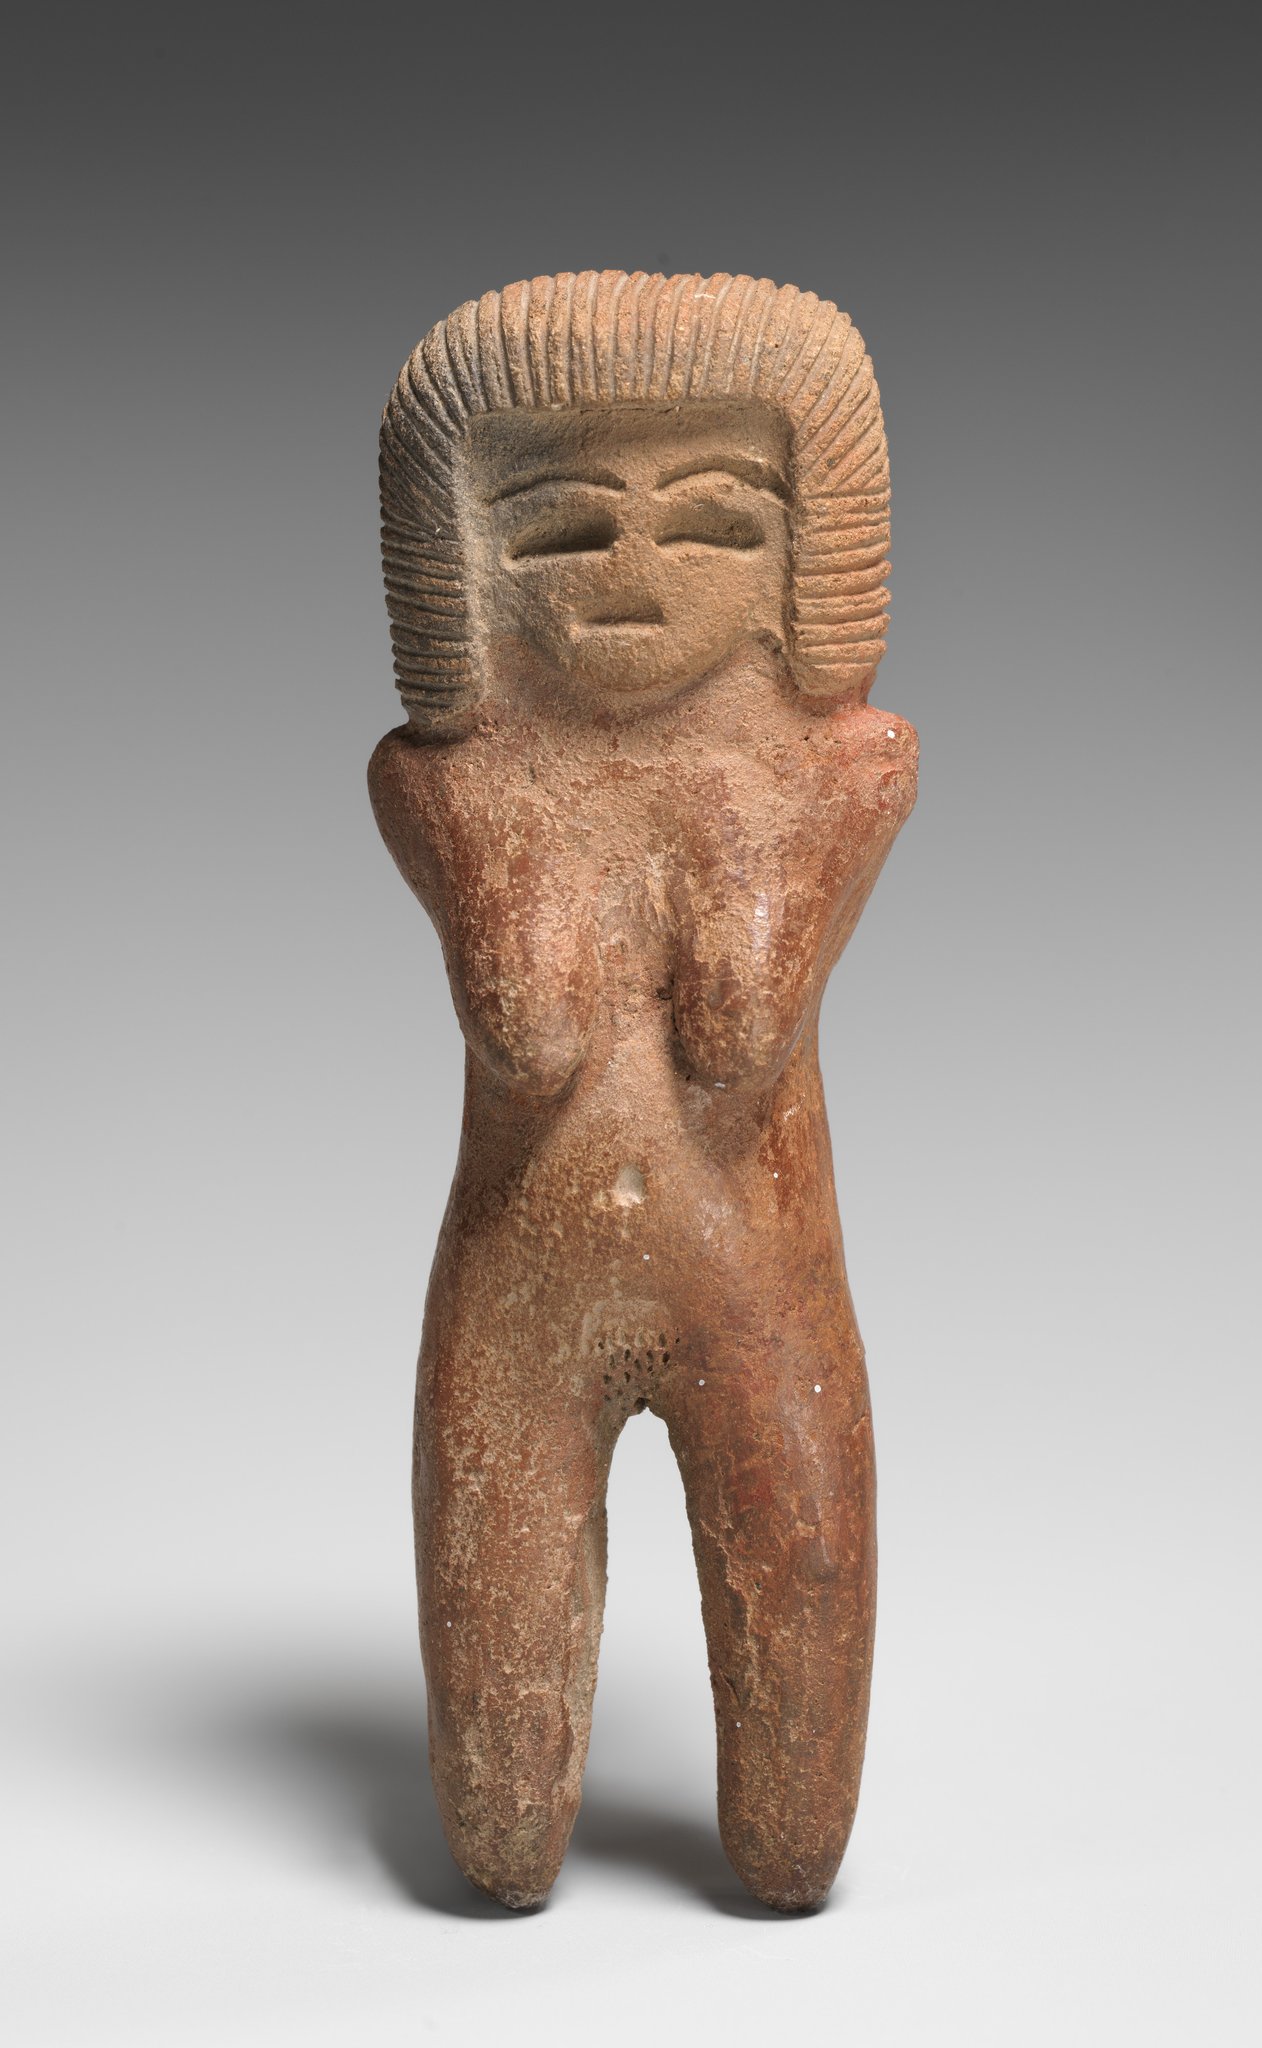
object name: female figure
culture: valdivia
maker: valdivia artist(s)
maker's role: artist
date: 3000 BCE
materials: ceramic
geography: ecuador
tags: female nudes